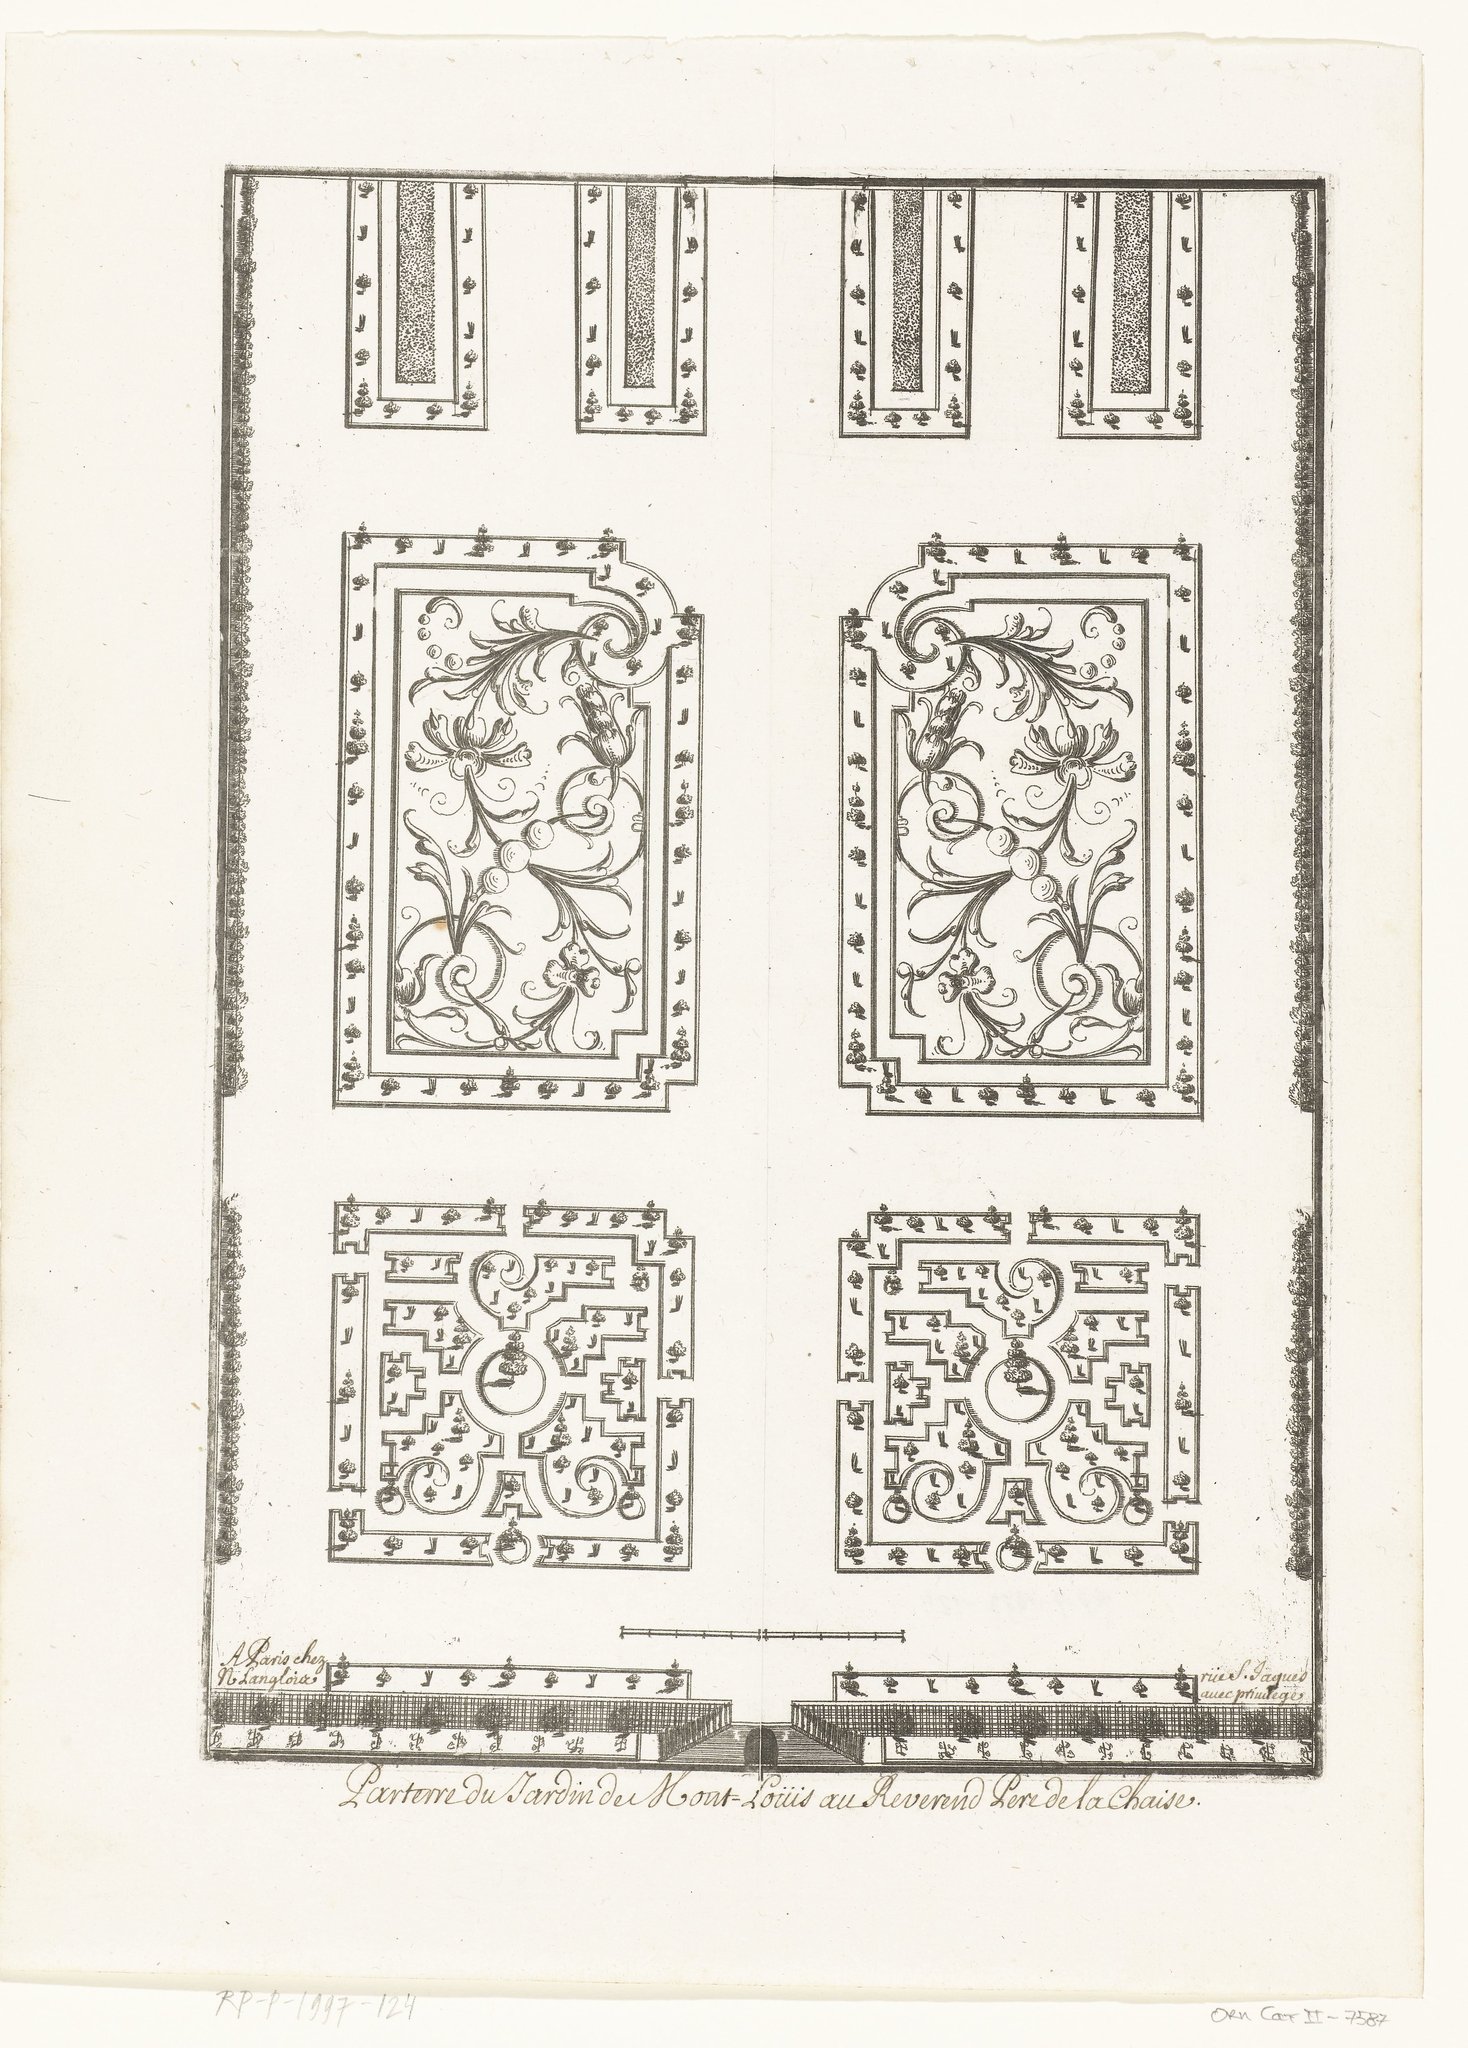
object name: ornament print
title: Parterre van de tuin van Mont-Louis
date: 1670-1680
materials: paper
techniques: etching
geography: france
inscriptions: signature and address: ‘A Paris chez N. Langlois; rue S. Jaques avec privilege.’, title: ‘Parterre du jardin de Mont-Louis au Reverend Pere de la Chaise.’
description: De linkerhelft is een tegendruk van de rechterhelft. Uit serie van 12 bladen.